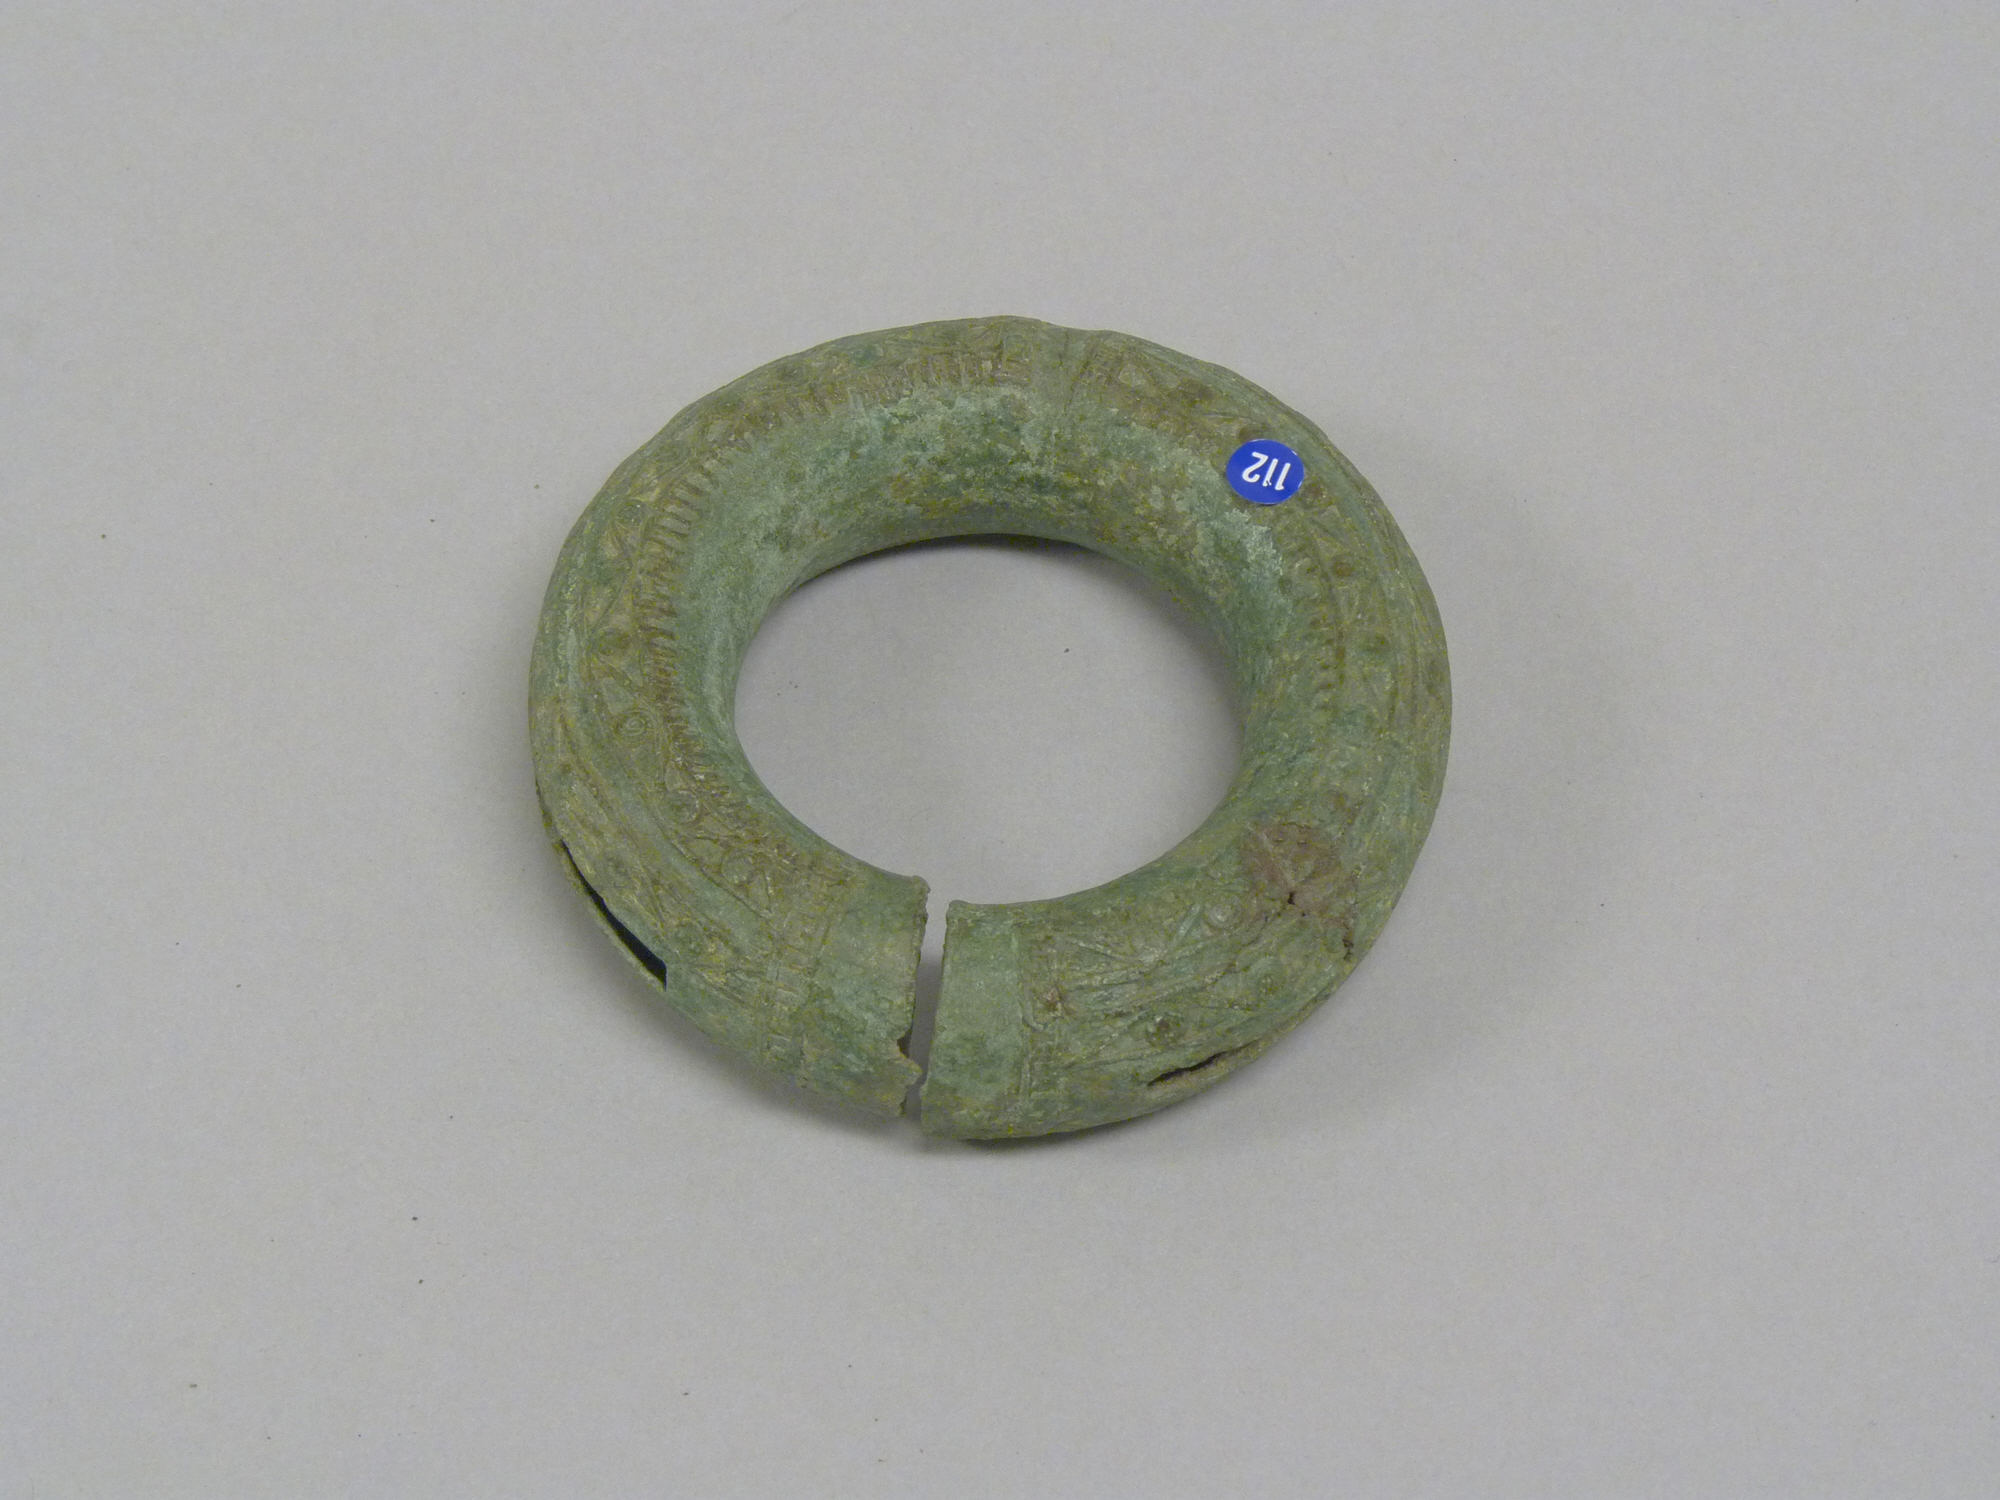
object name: bangle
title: Hollow Bangle with Pellets and Decoration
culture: thai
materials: bronze